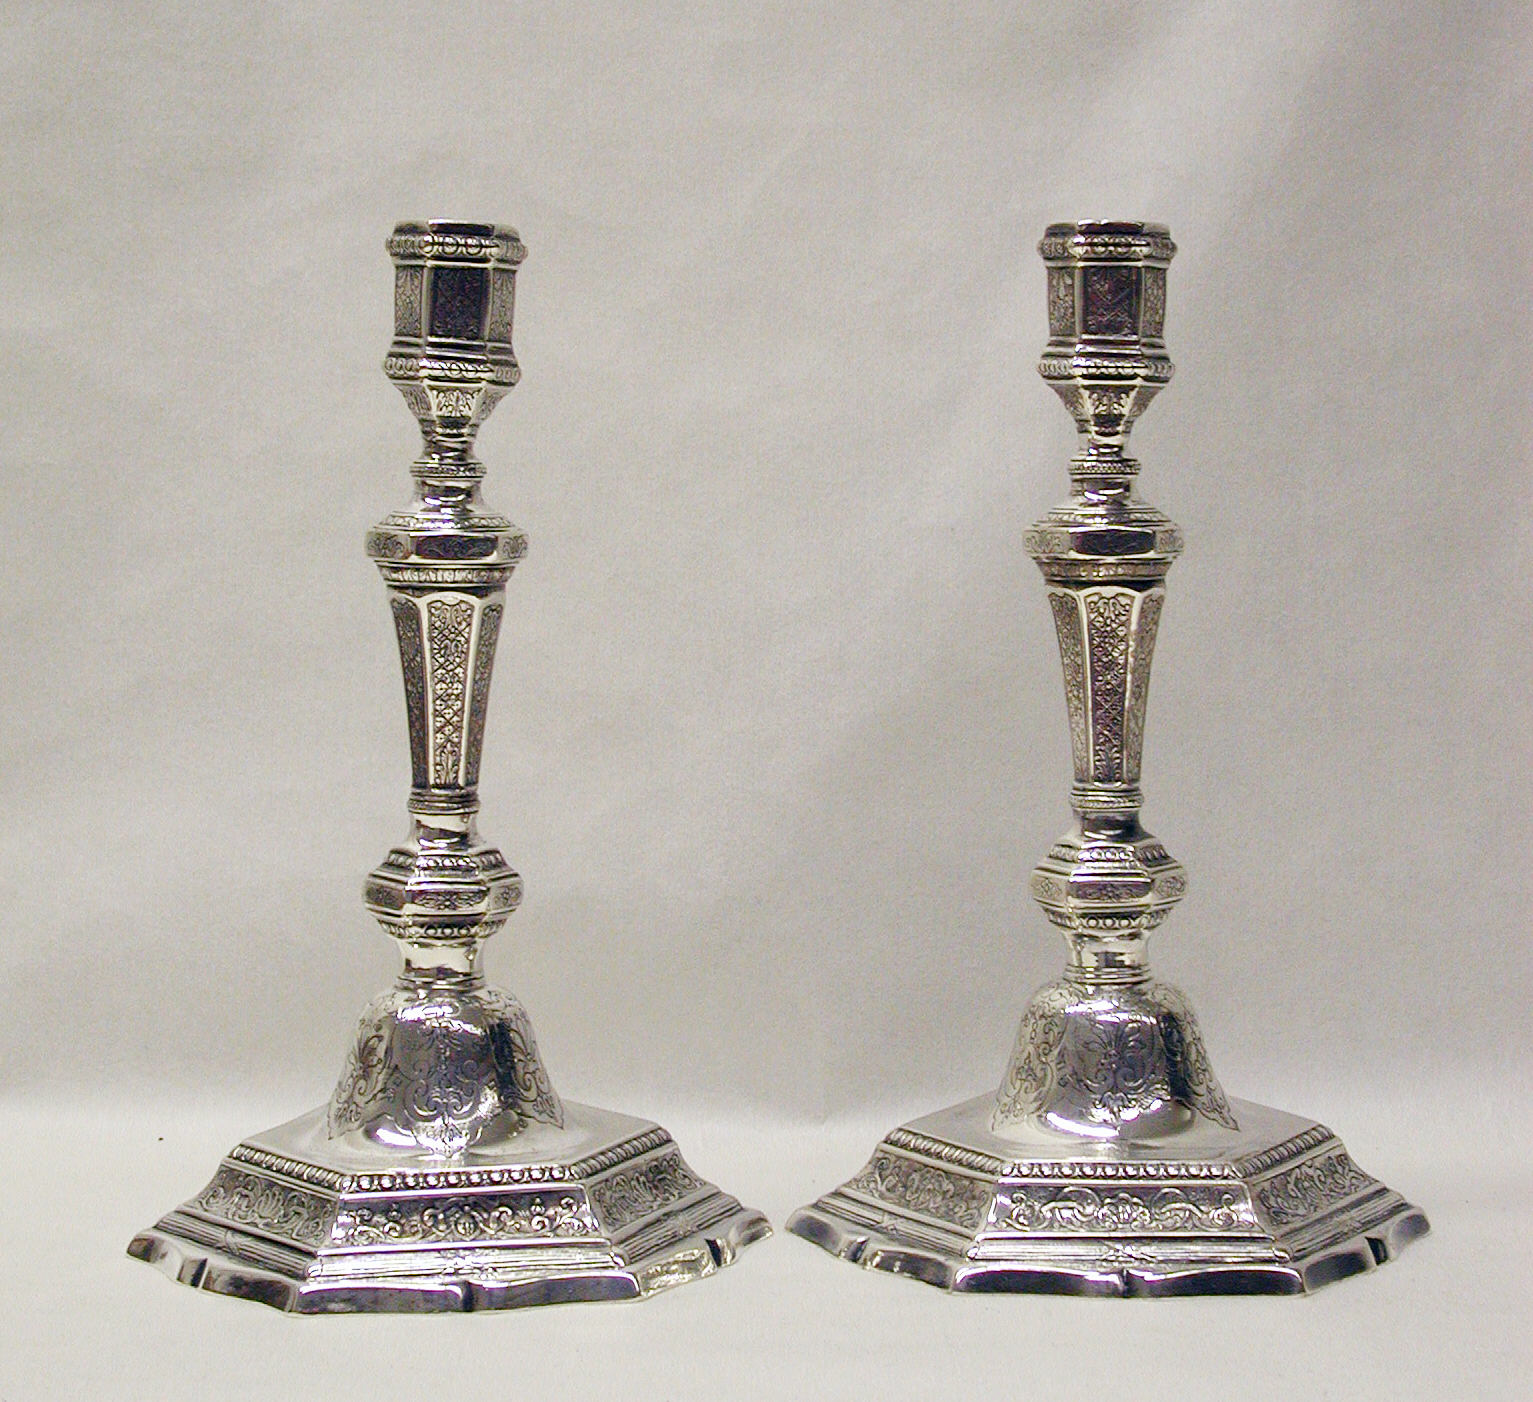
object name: candlestick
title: Pair of candlesticks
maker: claude roysard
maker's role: maker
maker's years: 1653-1753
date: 1751-1752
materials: silver